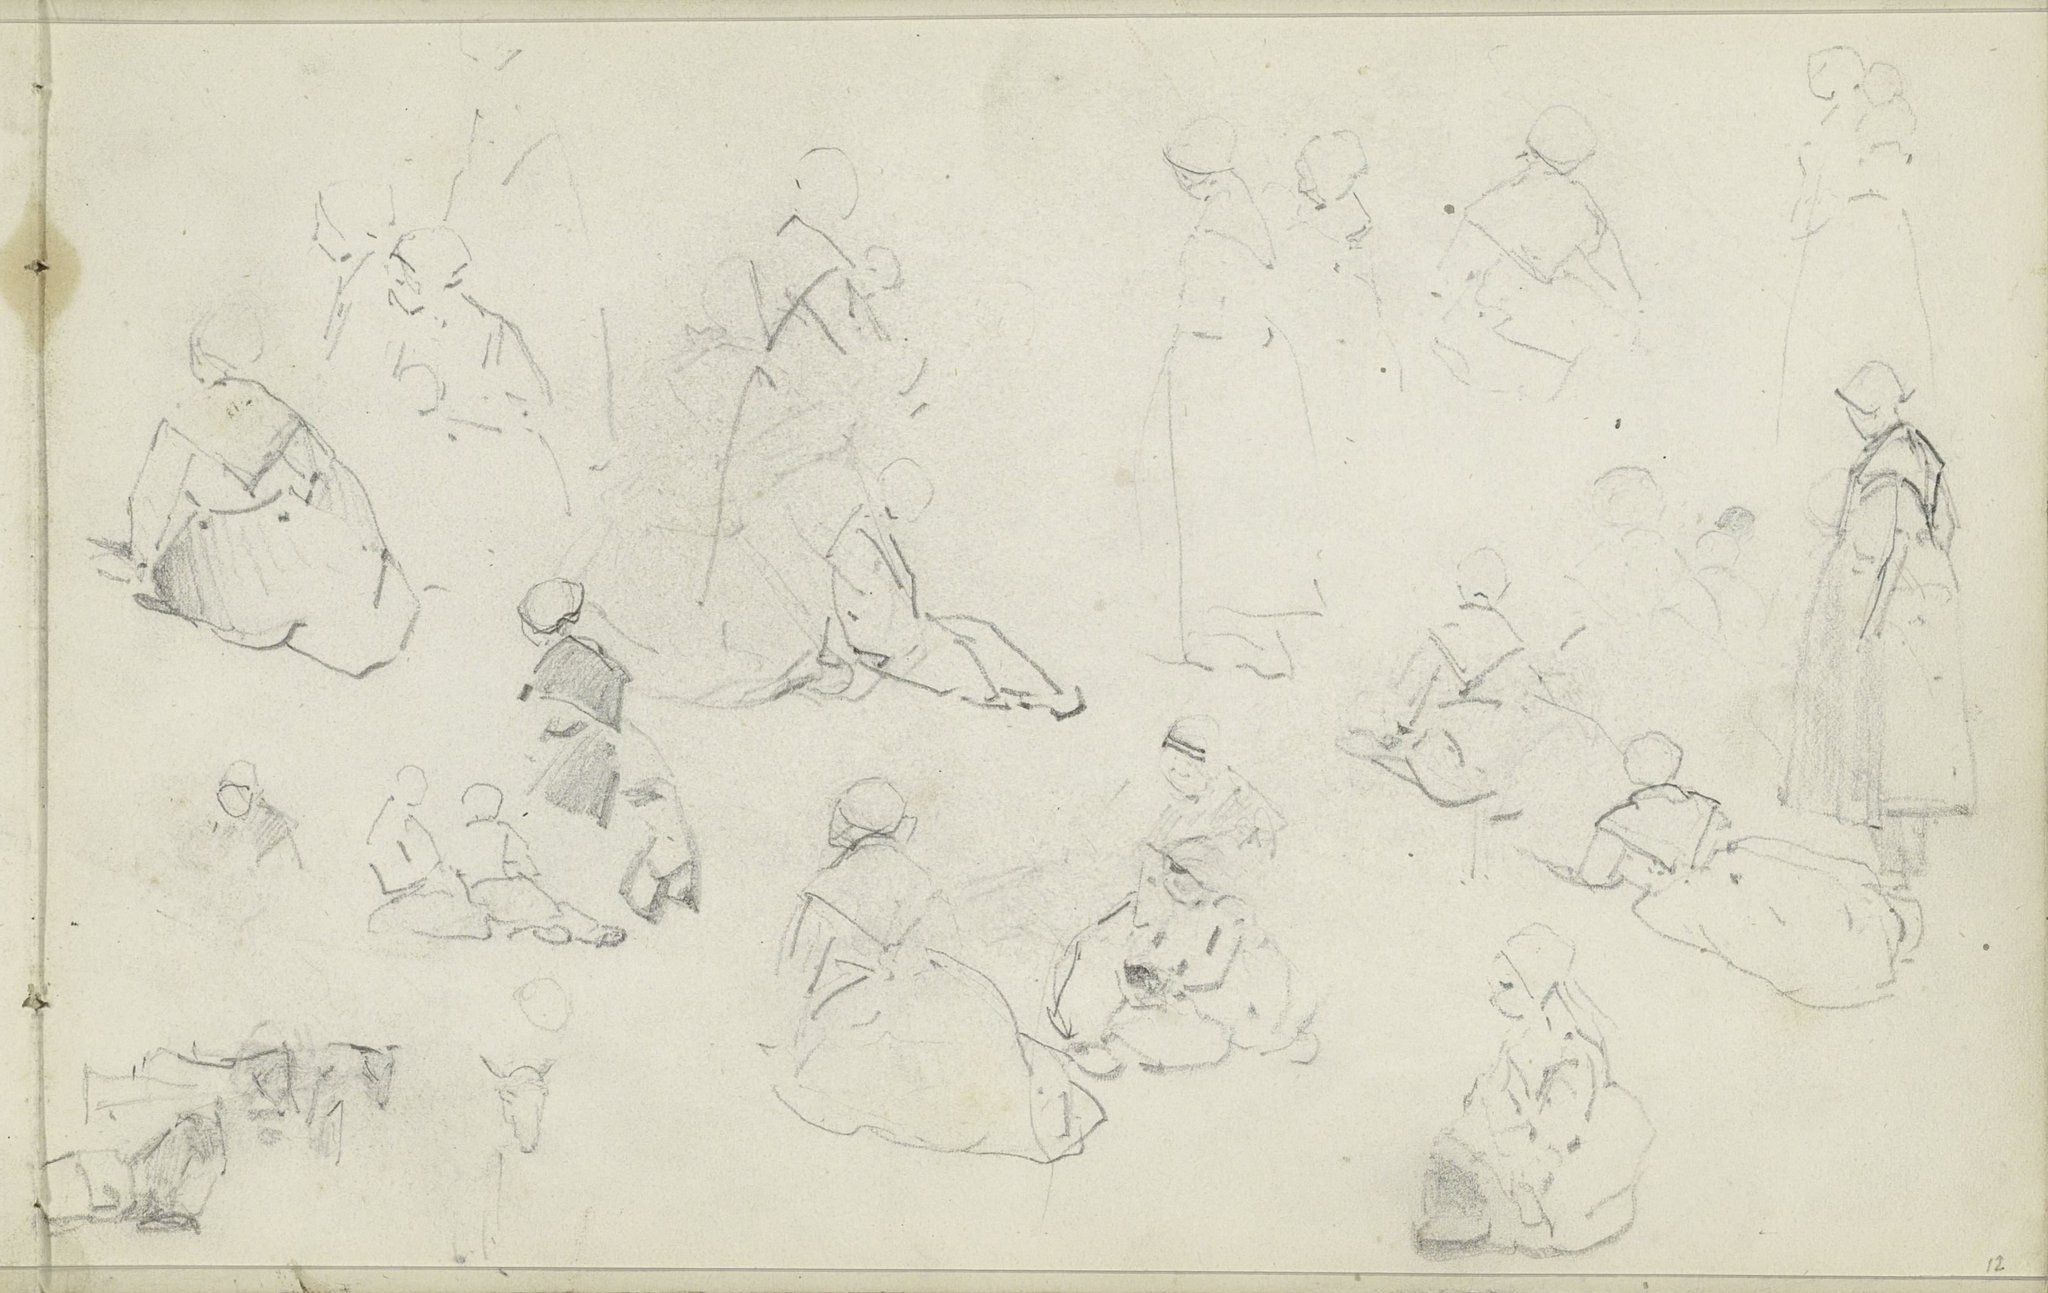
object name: sketchbook leaf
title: Vrouwen en kinderen in Scheveningse dracht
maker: johannes bosboom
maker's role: draughtsman, painter, print maker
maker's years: 1817-1891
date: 1873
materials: paper, pencil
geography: scheveningen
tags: folk costume, regional costume (+ women's clothes)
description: Blad 12 recto uit een schetsboek met 39 bladen.